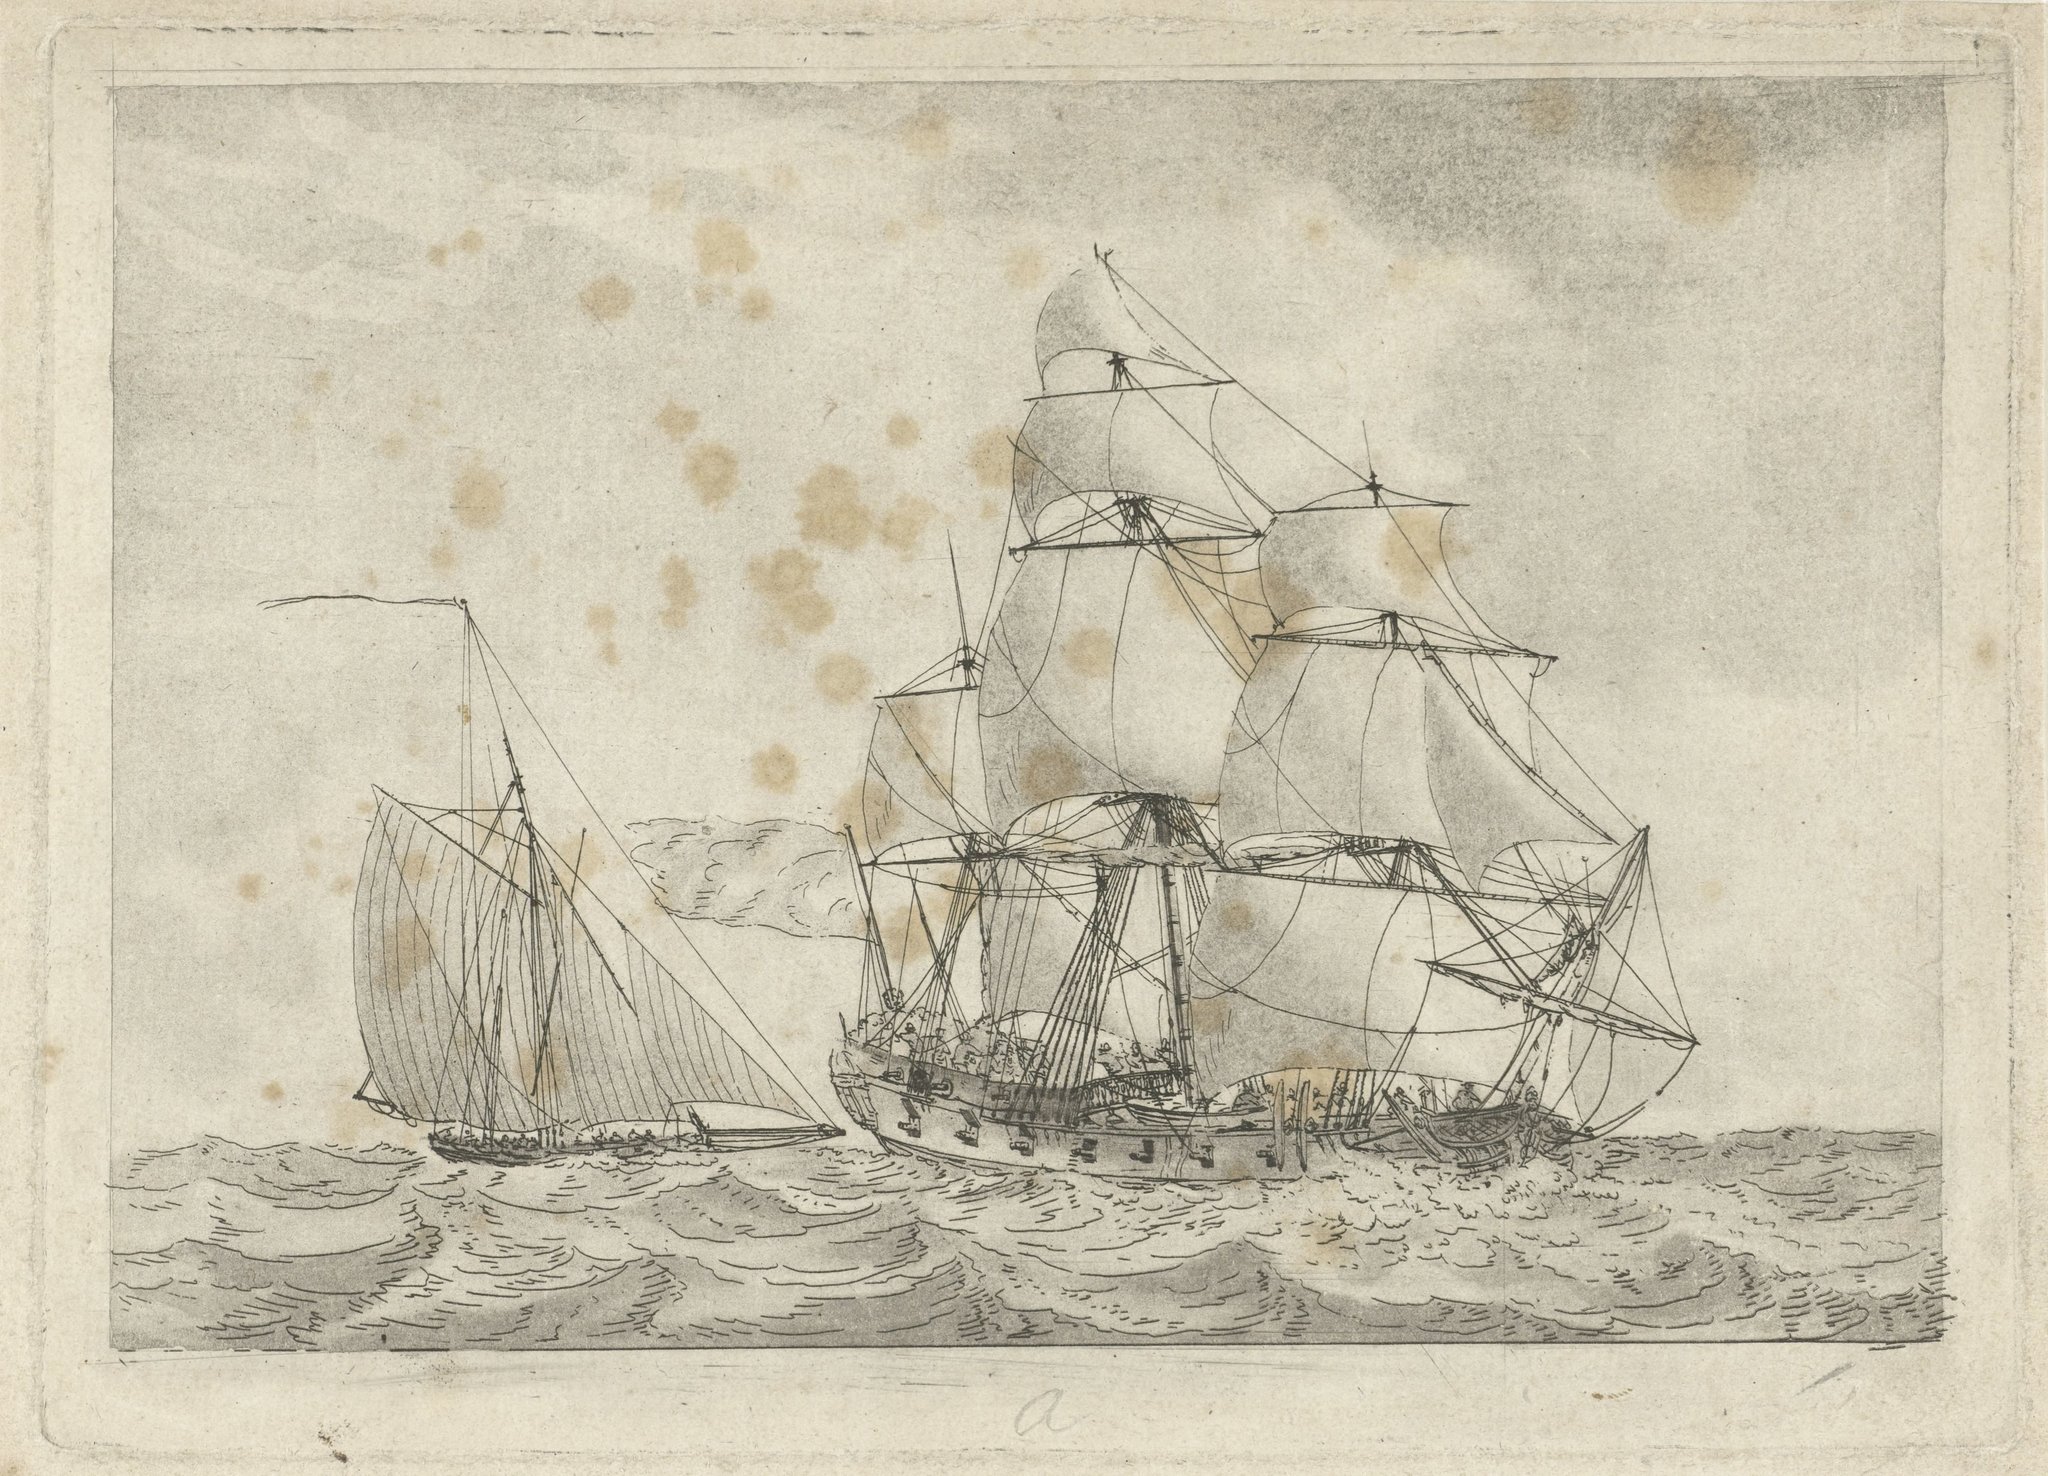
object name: print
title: Kotter en een oorlogsfregat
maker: gerrit groenewegen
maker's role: draughtsman, print maker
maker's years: 1754-1826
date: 1764-1826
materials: paper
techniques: aquatint, etching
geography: rotterdam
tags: ships (in general)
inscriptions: collector's mark: Lugt 2228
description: Een driemaster met een vlag en een kleine zeilschip op de golven.